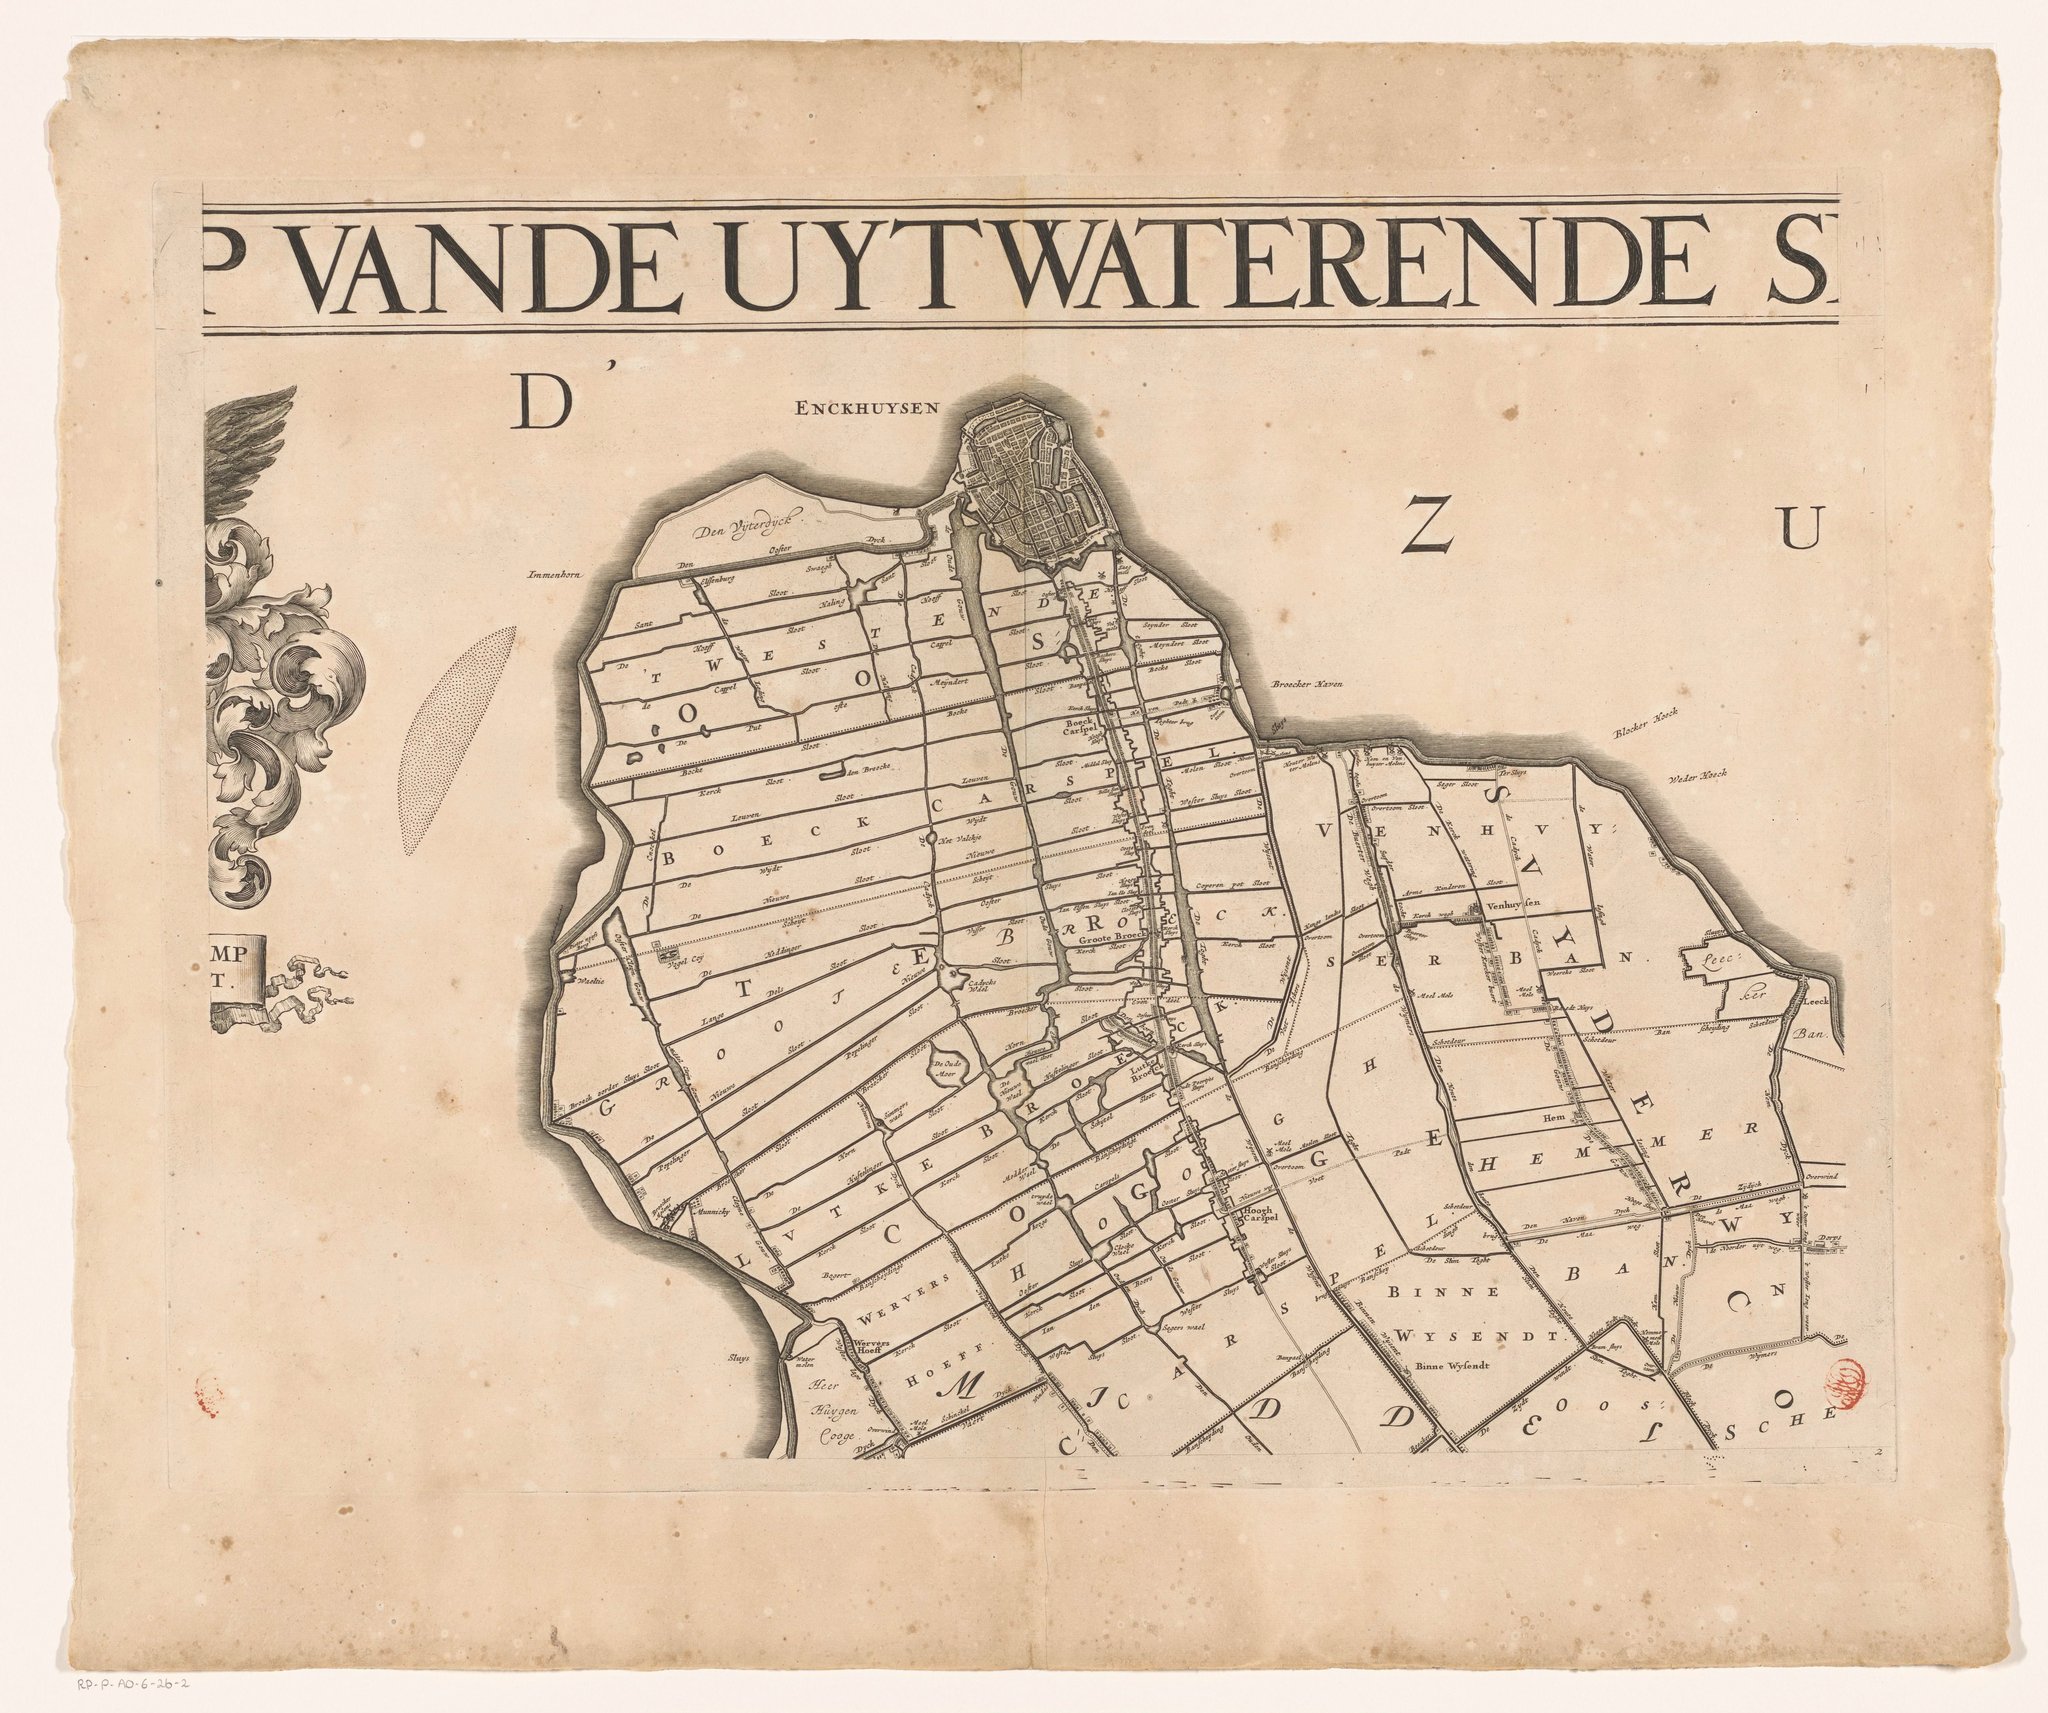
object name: print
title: Kaart van Kennemerland en West-Friesland (tweede deel)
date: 1680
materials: paper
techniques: engraving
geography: amsterdam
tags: coat of arms (as symbol of the state, etc.), maps of separate countries or regions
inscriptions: collector's mark: Lugt 195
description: Tweede deel van een kaart van Kennemerland en West-Friesland. Rechtsonder genummerd: 2.